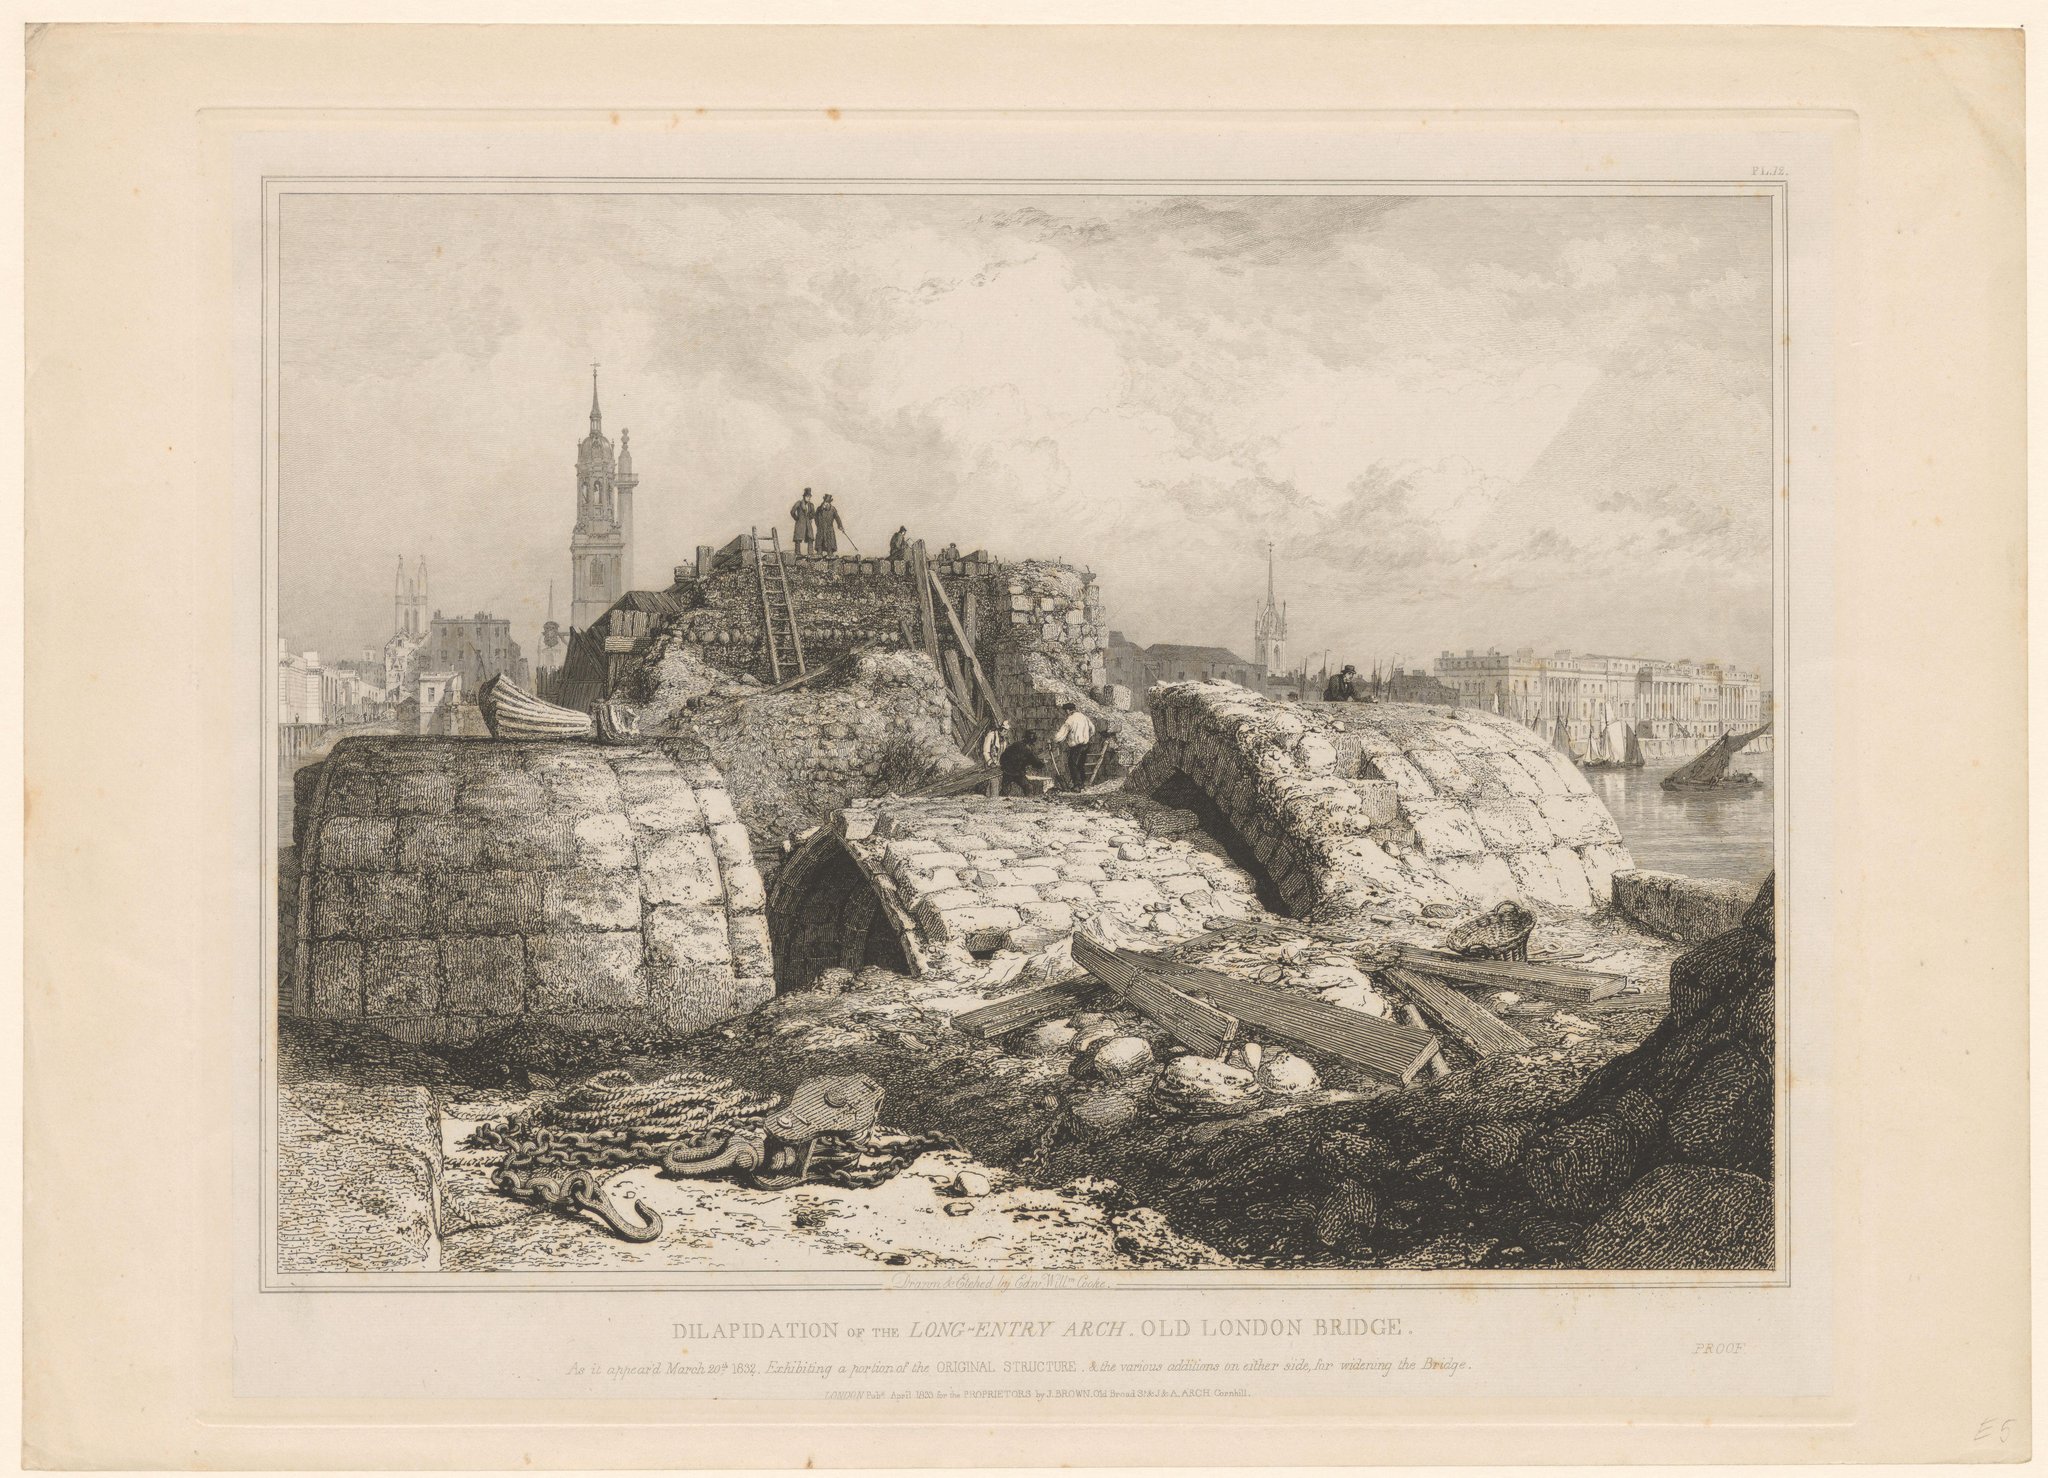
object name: print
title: Views of the Old and New London Bridges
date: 1804-1833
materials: paper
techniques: etching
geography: london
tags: sailing-ship, sailing-boat, church (exterior), canals, waters (in city)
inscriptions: collector's mark: Lugt 2165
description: Bij de prentenserie hoort een titelprent uit 1833 en een beschrijving van de bruggen.